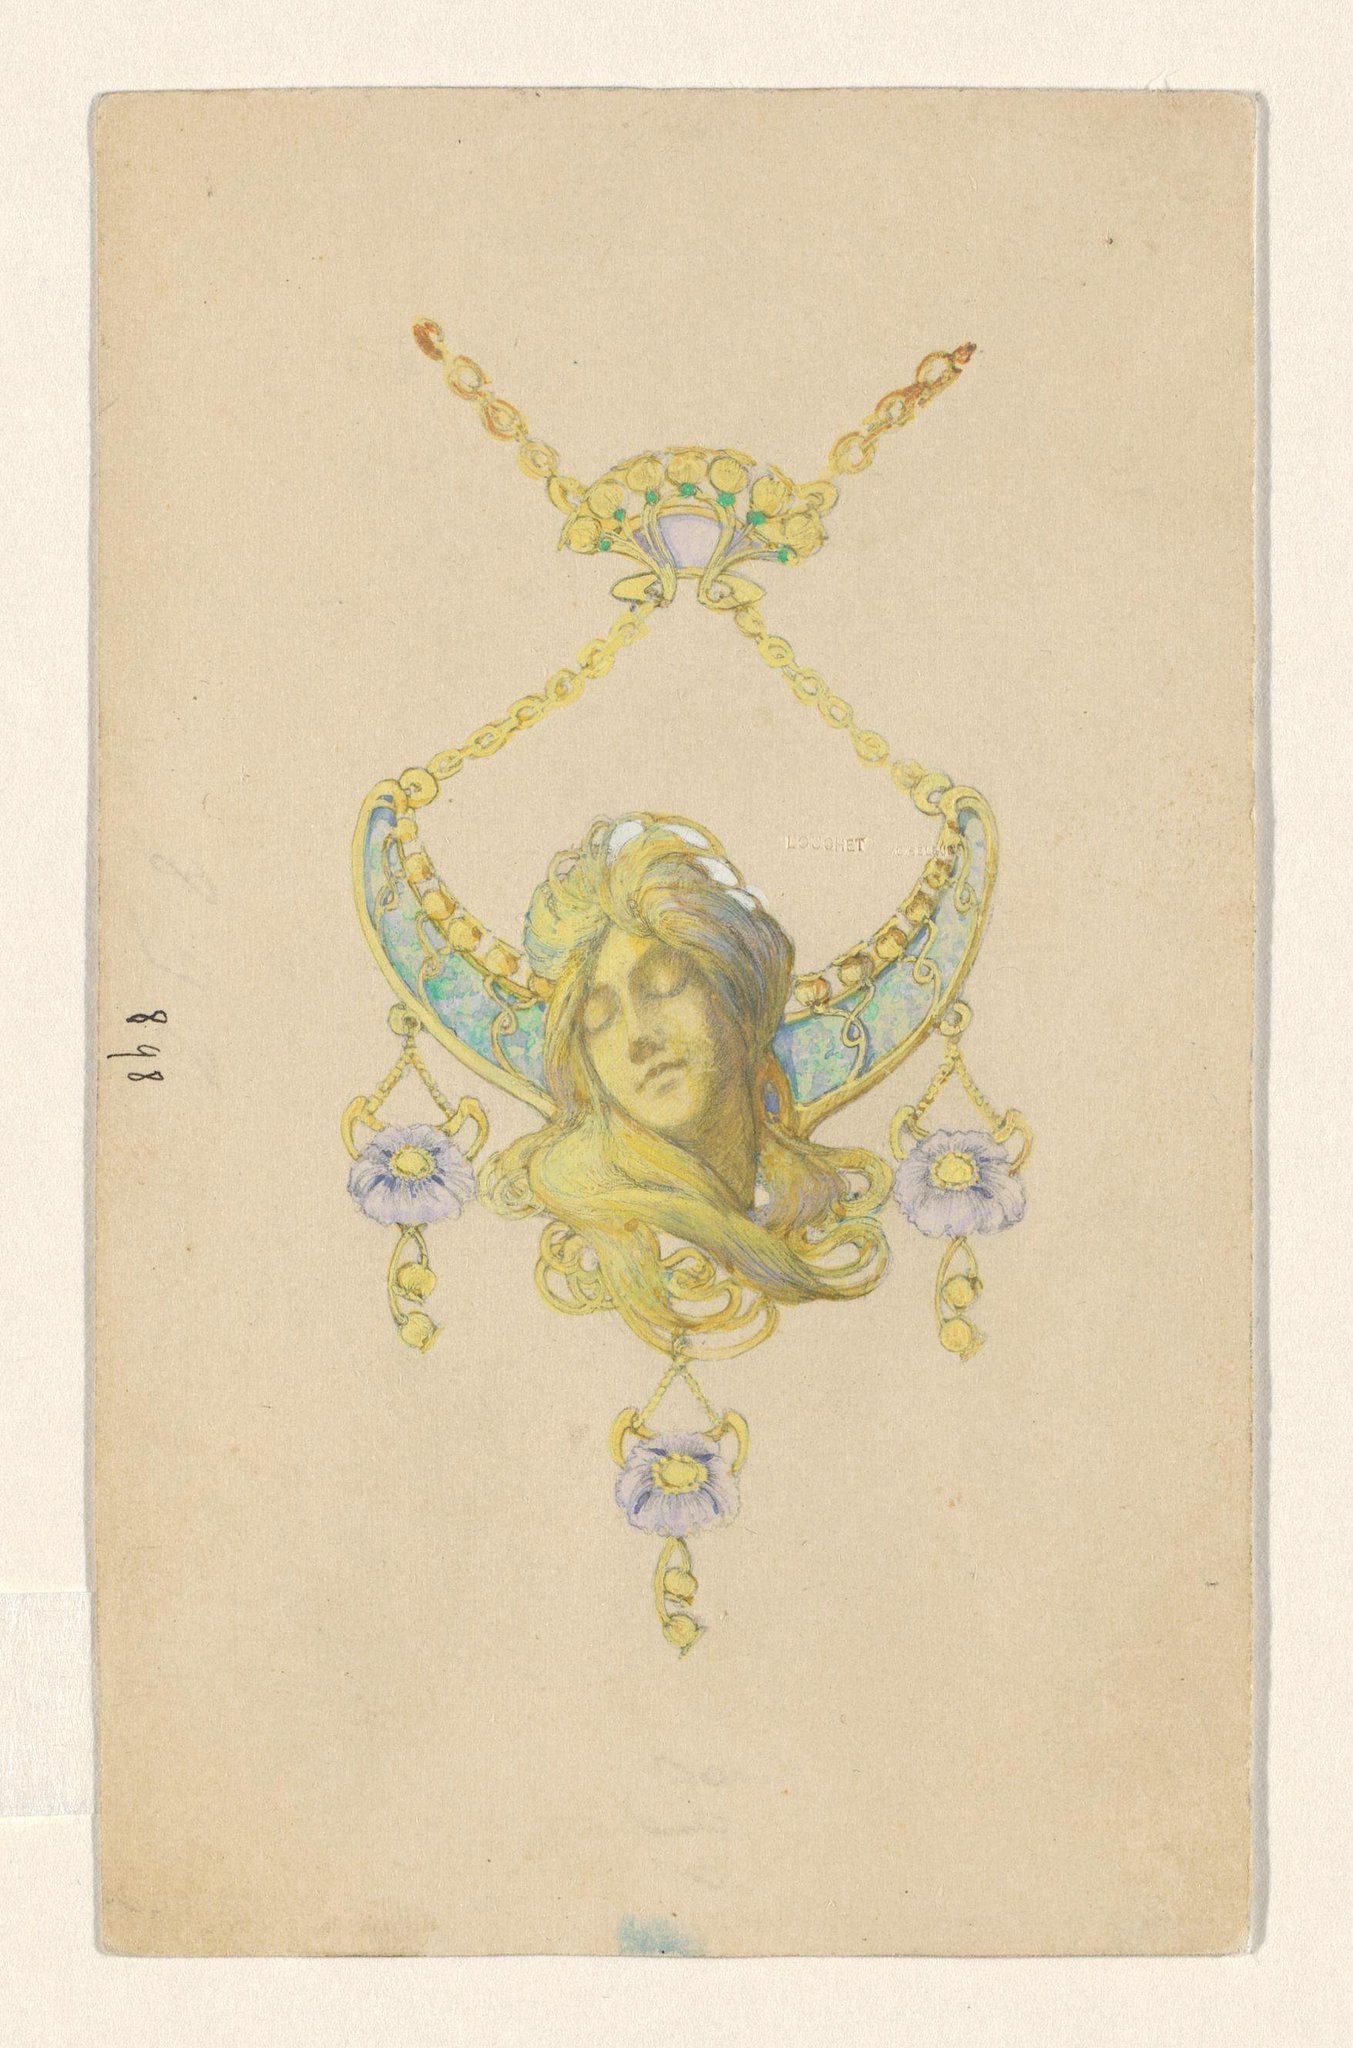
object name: design drawing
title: Ontwerp voor een hanger met een slapend vrouwenhoofd en papavers, van geëmailleerd goud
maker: paul louchet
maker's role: painter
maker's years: 1854-1936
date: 1905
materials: gouache, graphite, ink, paper, watercolor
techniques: aquarelle, drawing, pen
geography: paris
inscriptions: number: ‘893’, name: ‘LOUCHET CISELEUR’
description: Verso een schets in grafiet van een gefacetteerde steen.